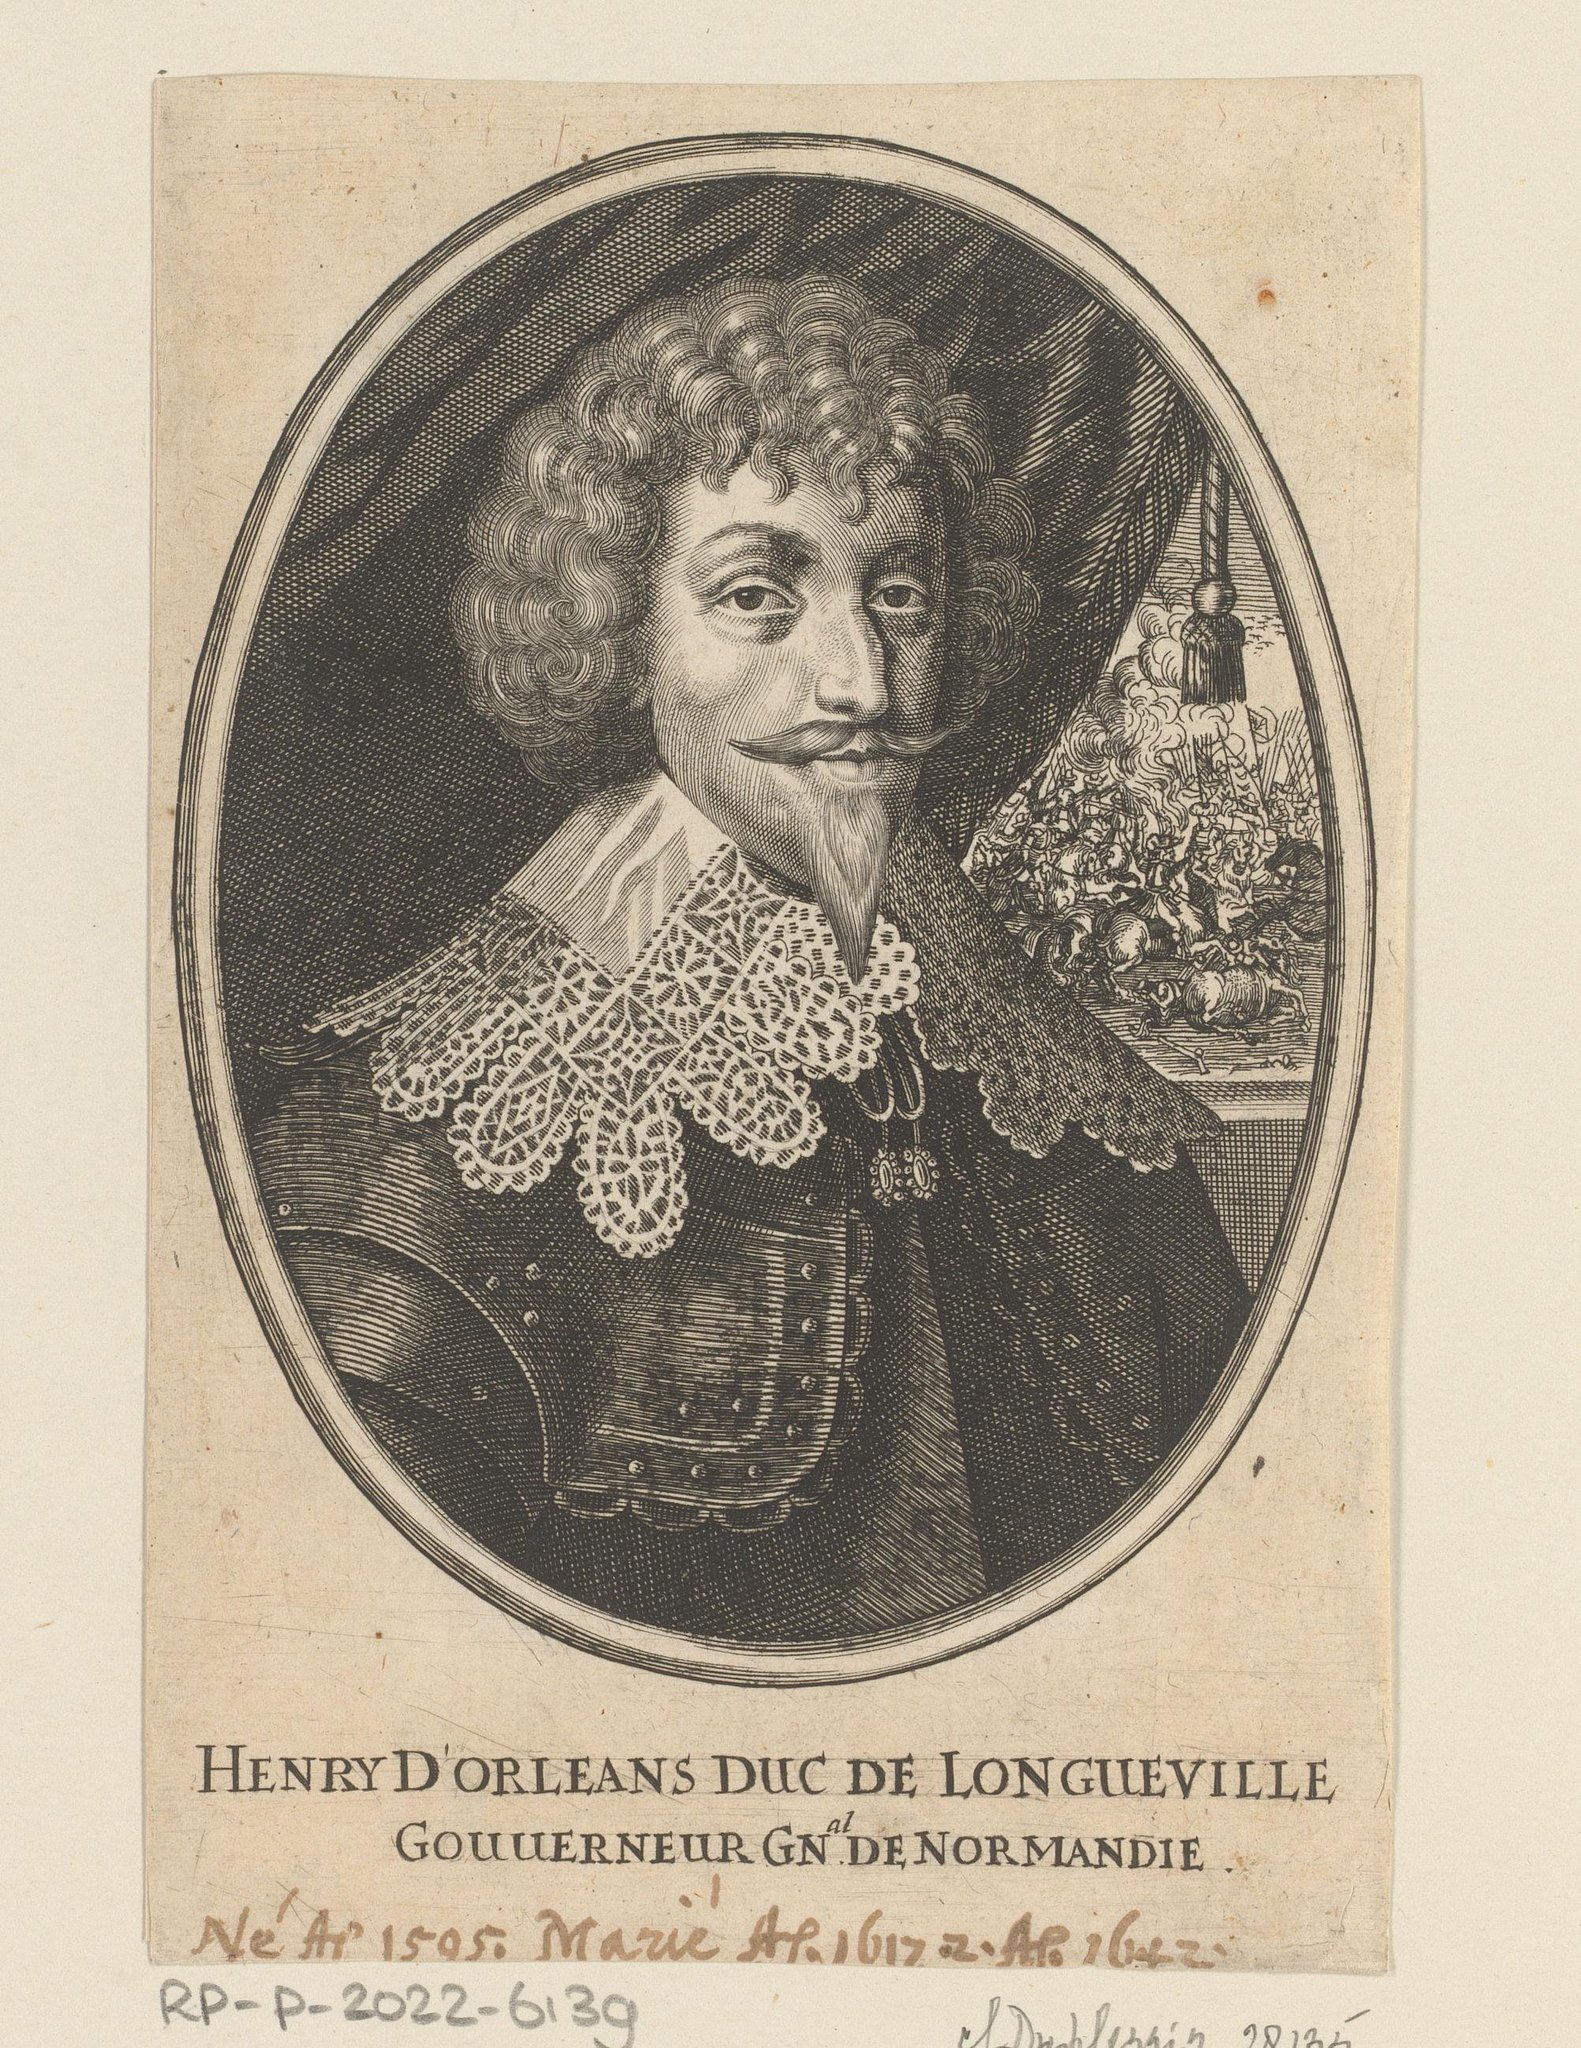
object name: print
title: Portret van Hendrik II van Longueville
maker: Anonymous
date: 1635-1686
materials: paper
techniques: engraving, etching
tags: historical persons, ruler, sovereign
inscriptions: inscription: ‘Né As 1595 Marié As. 1617.2.As.1642. (?)’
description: Met tweeregelig onderschrift in het Frans.